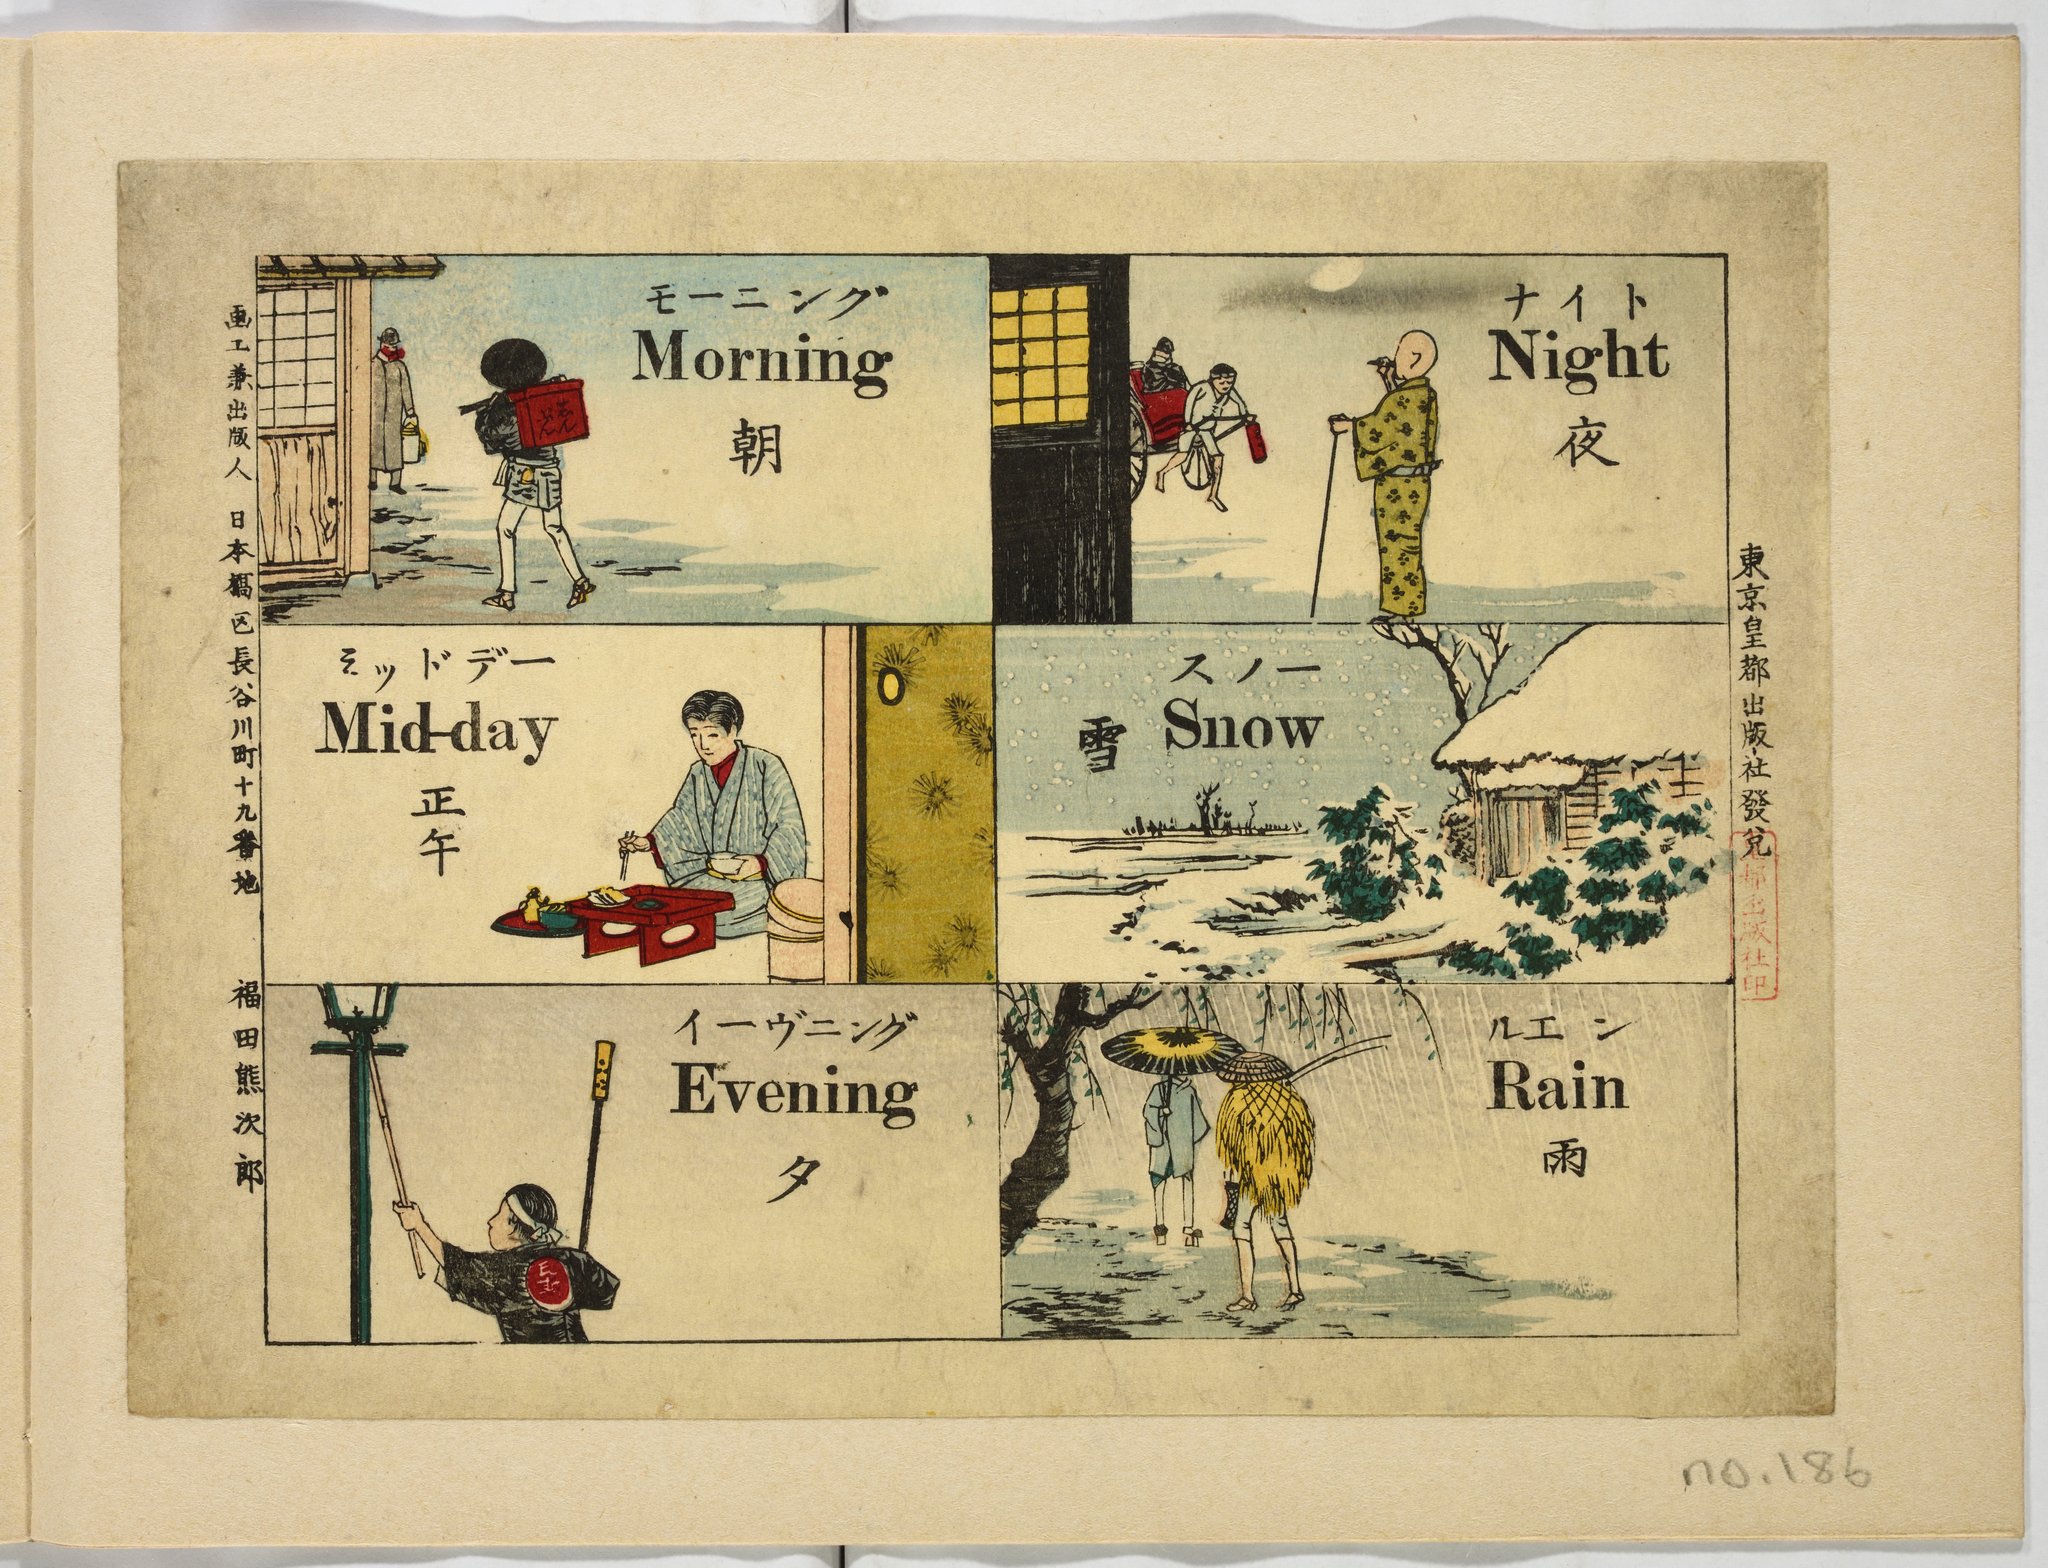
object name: illustrated book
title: A Study Book with English Titles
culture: japanese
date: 1887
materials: ink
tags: night,rain,snow